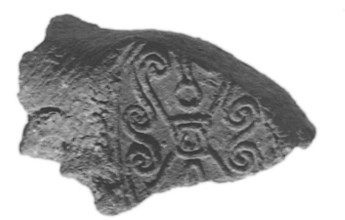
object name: sealing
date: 2030-1640 BCE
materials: clay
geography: egypt